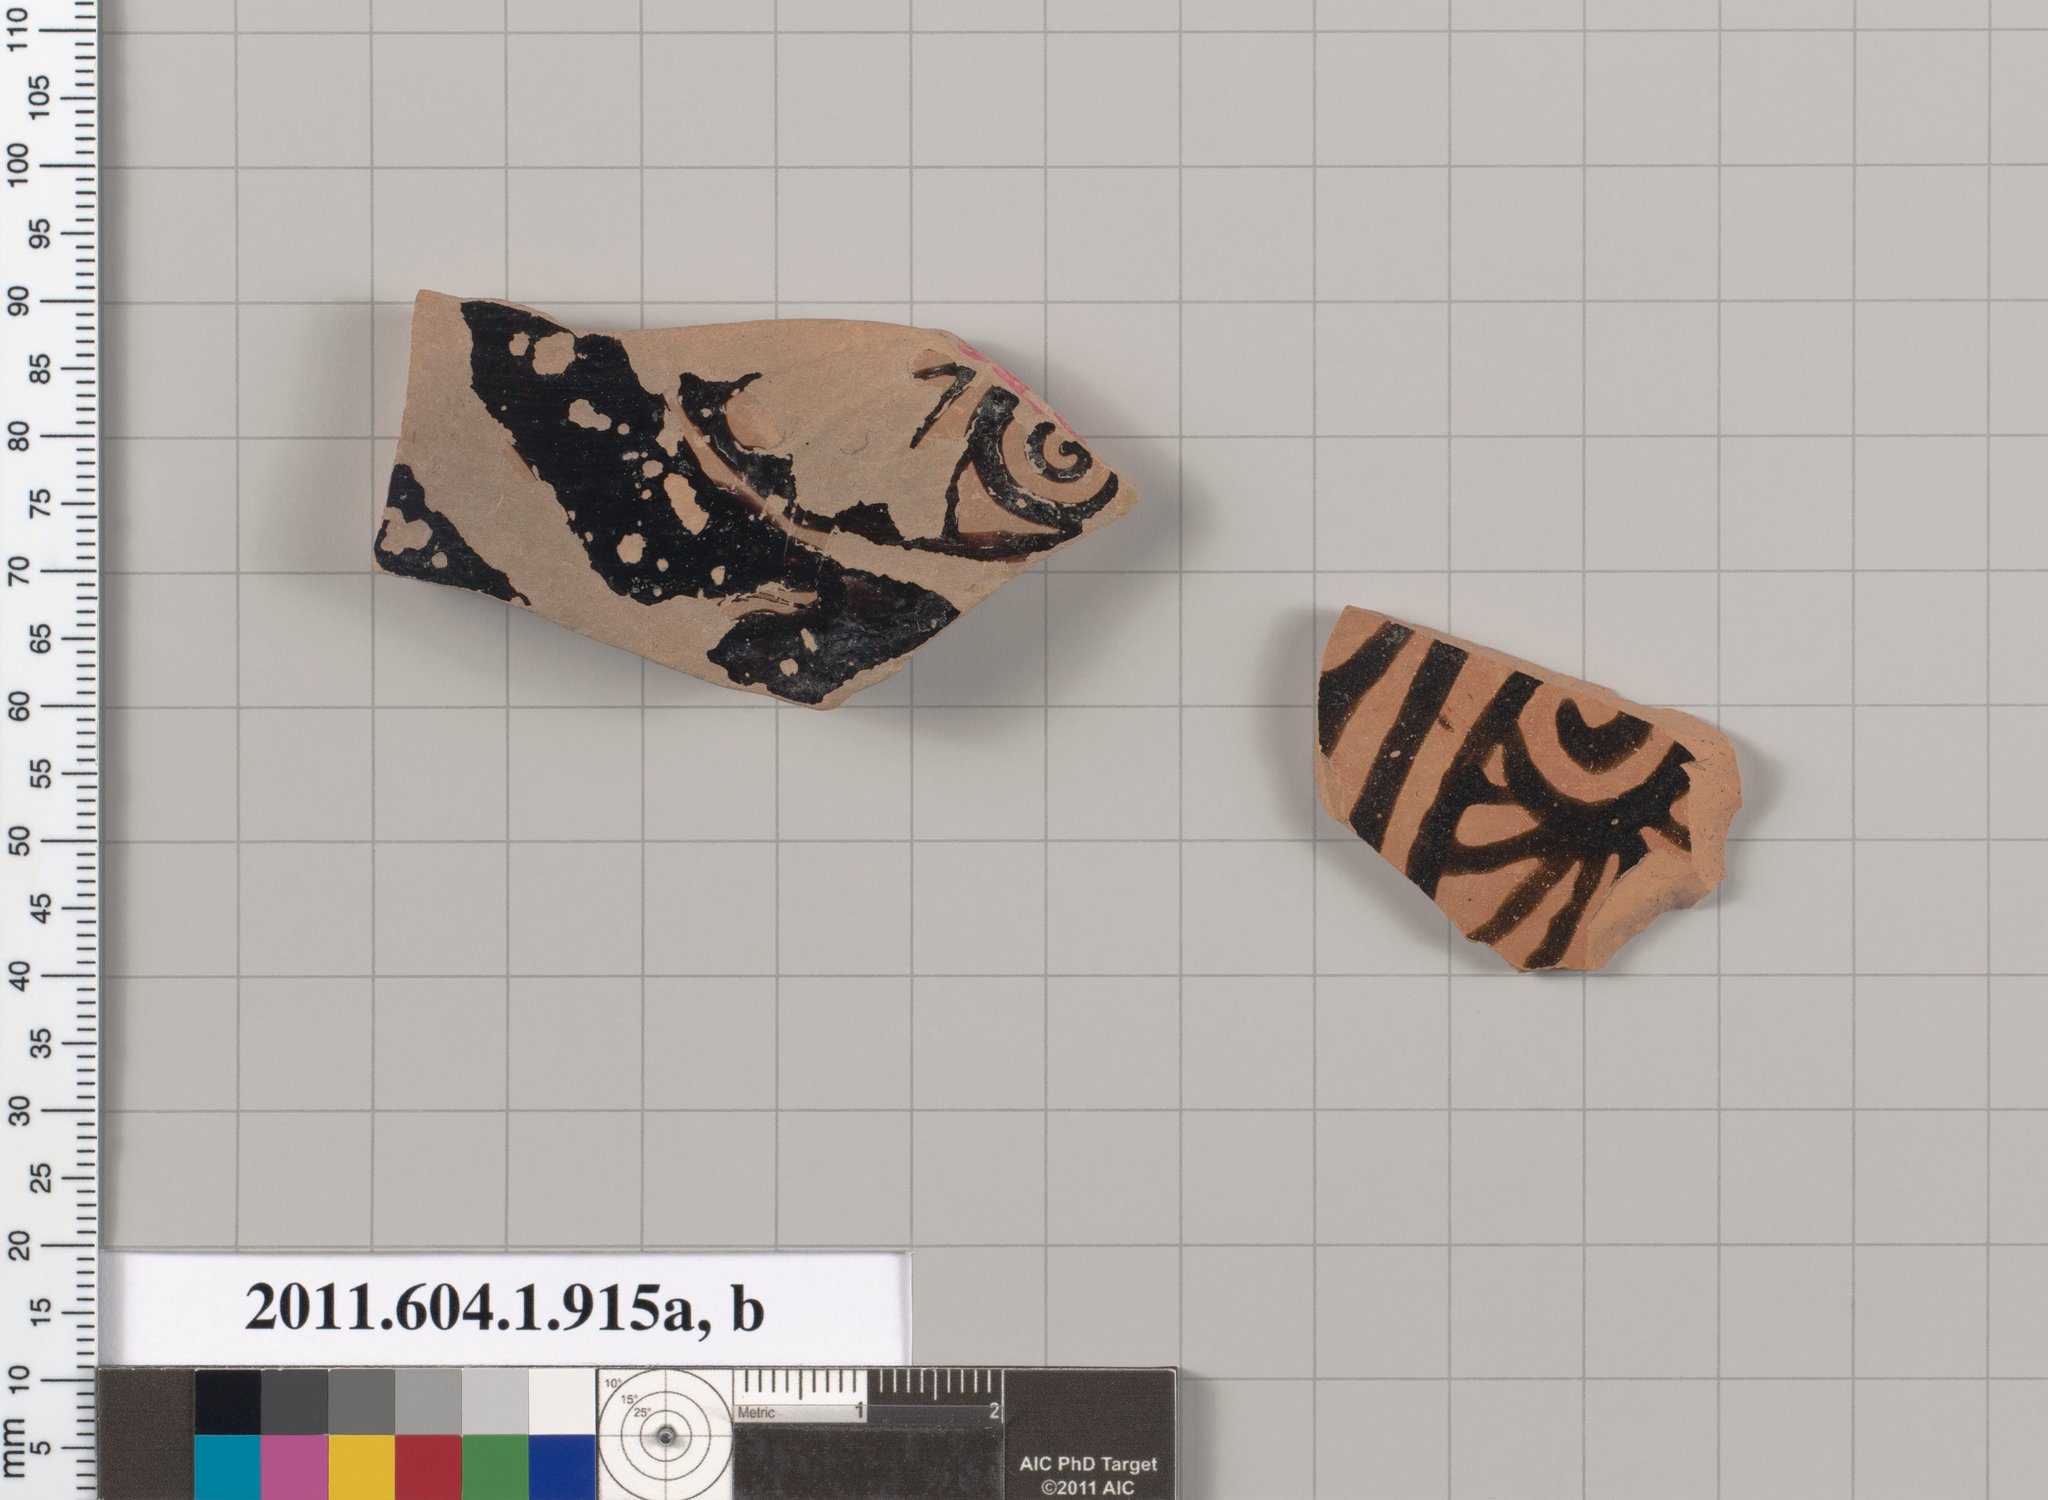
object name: kylix fragment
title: Terracotta fragments of kylikes (drinking cups)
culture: greek, attic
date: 467-435 BCE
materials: terracotta